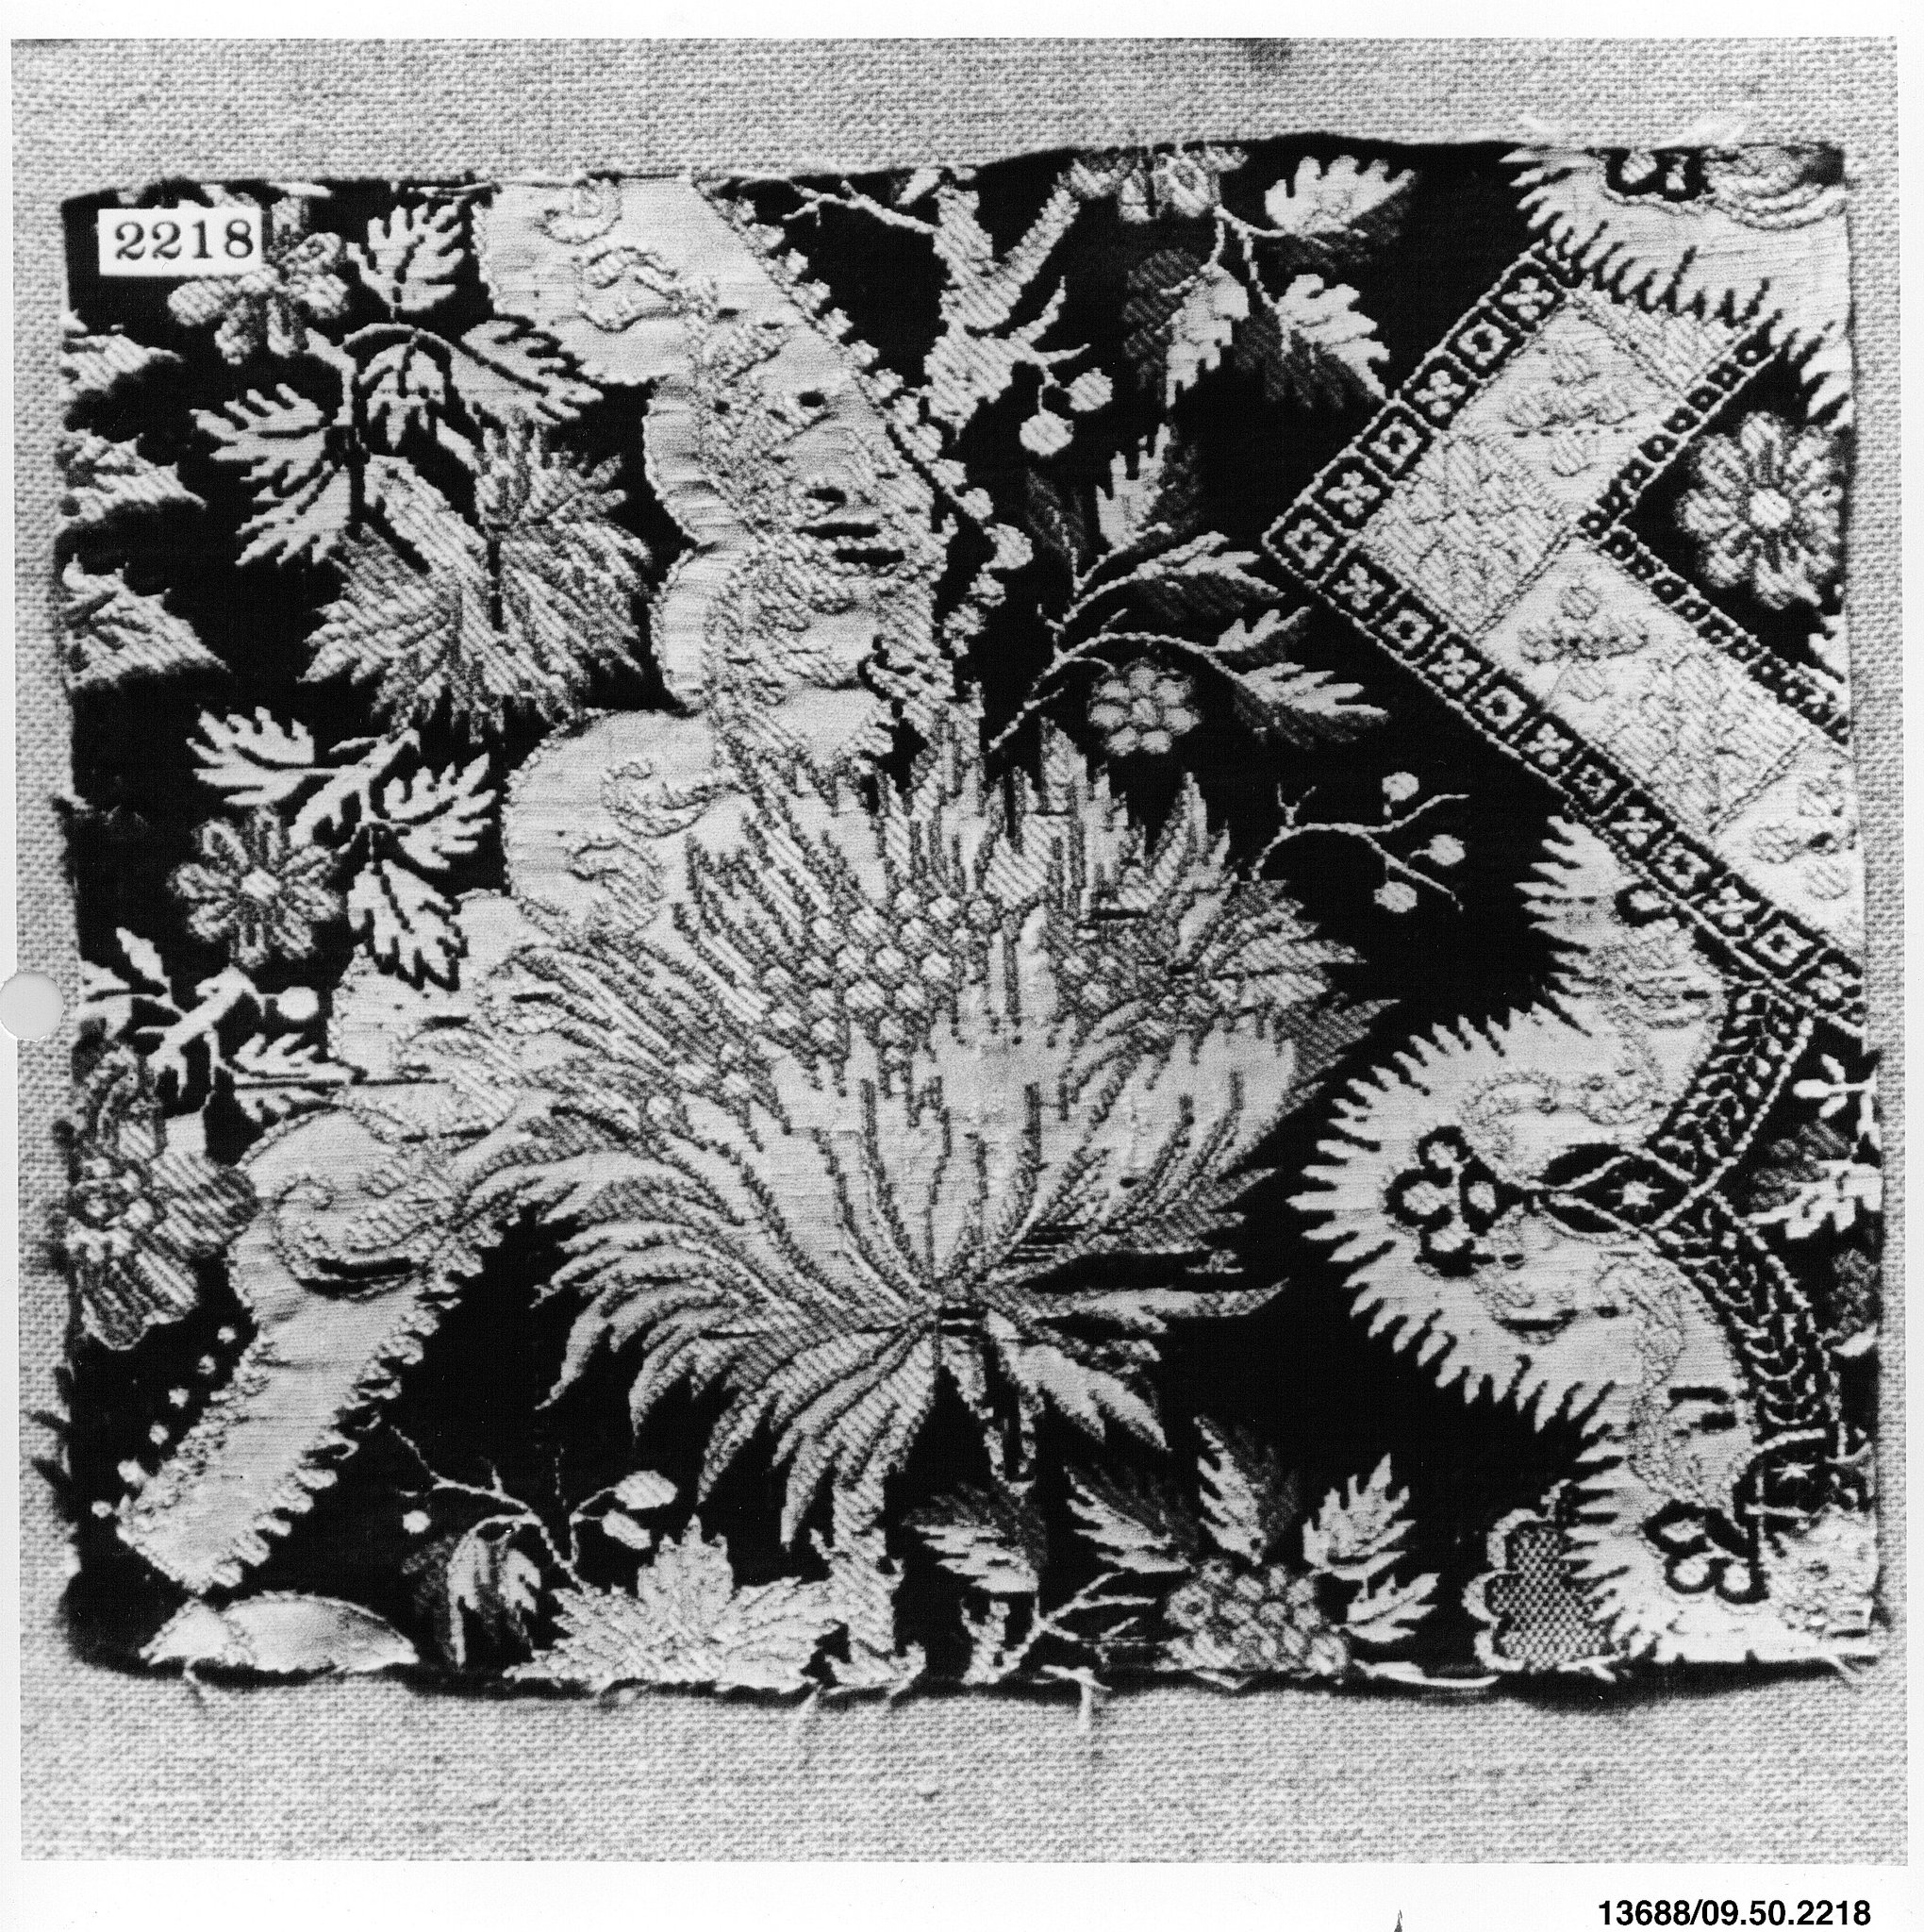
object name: piece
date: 1725-1730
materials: silk